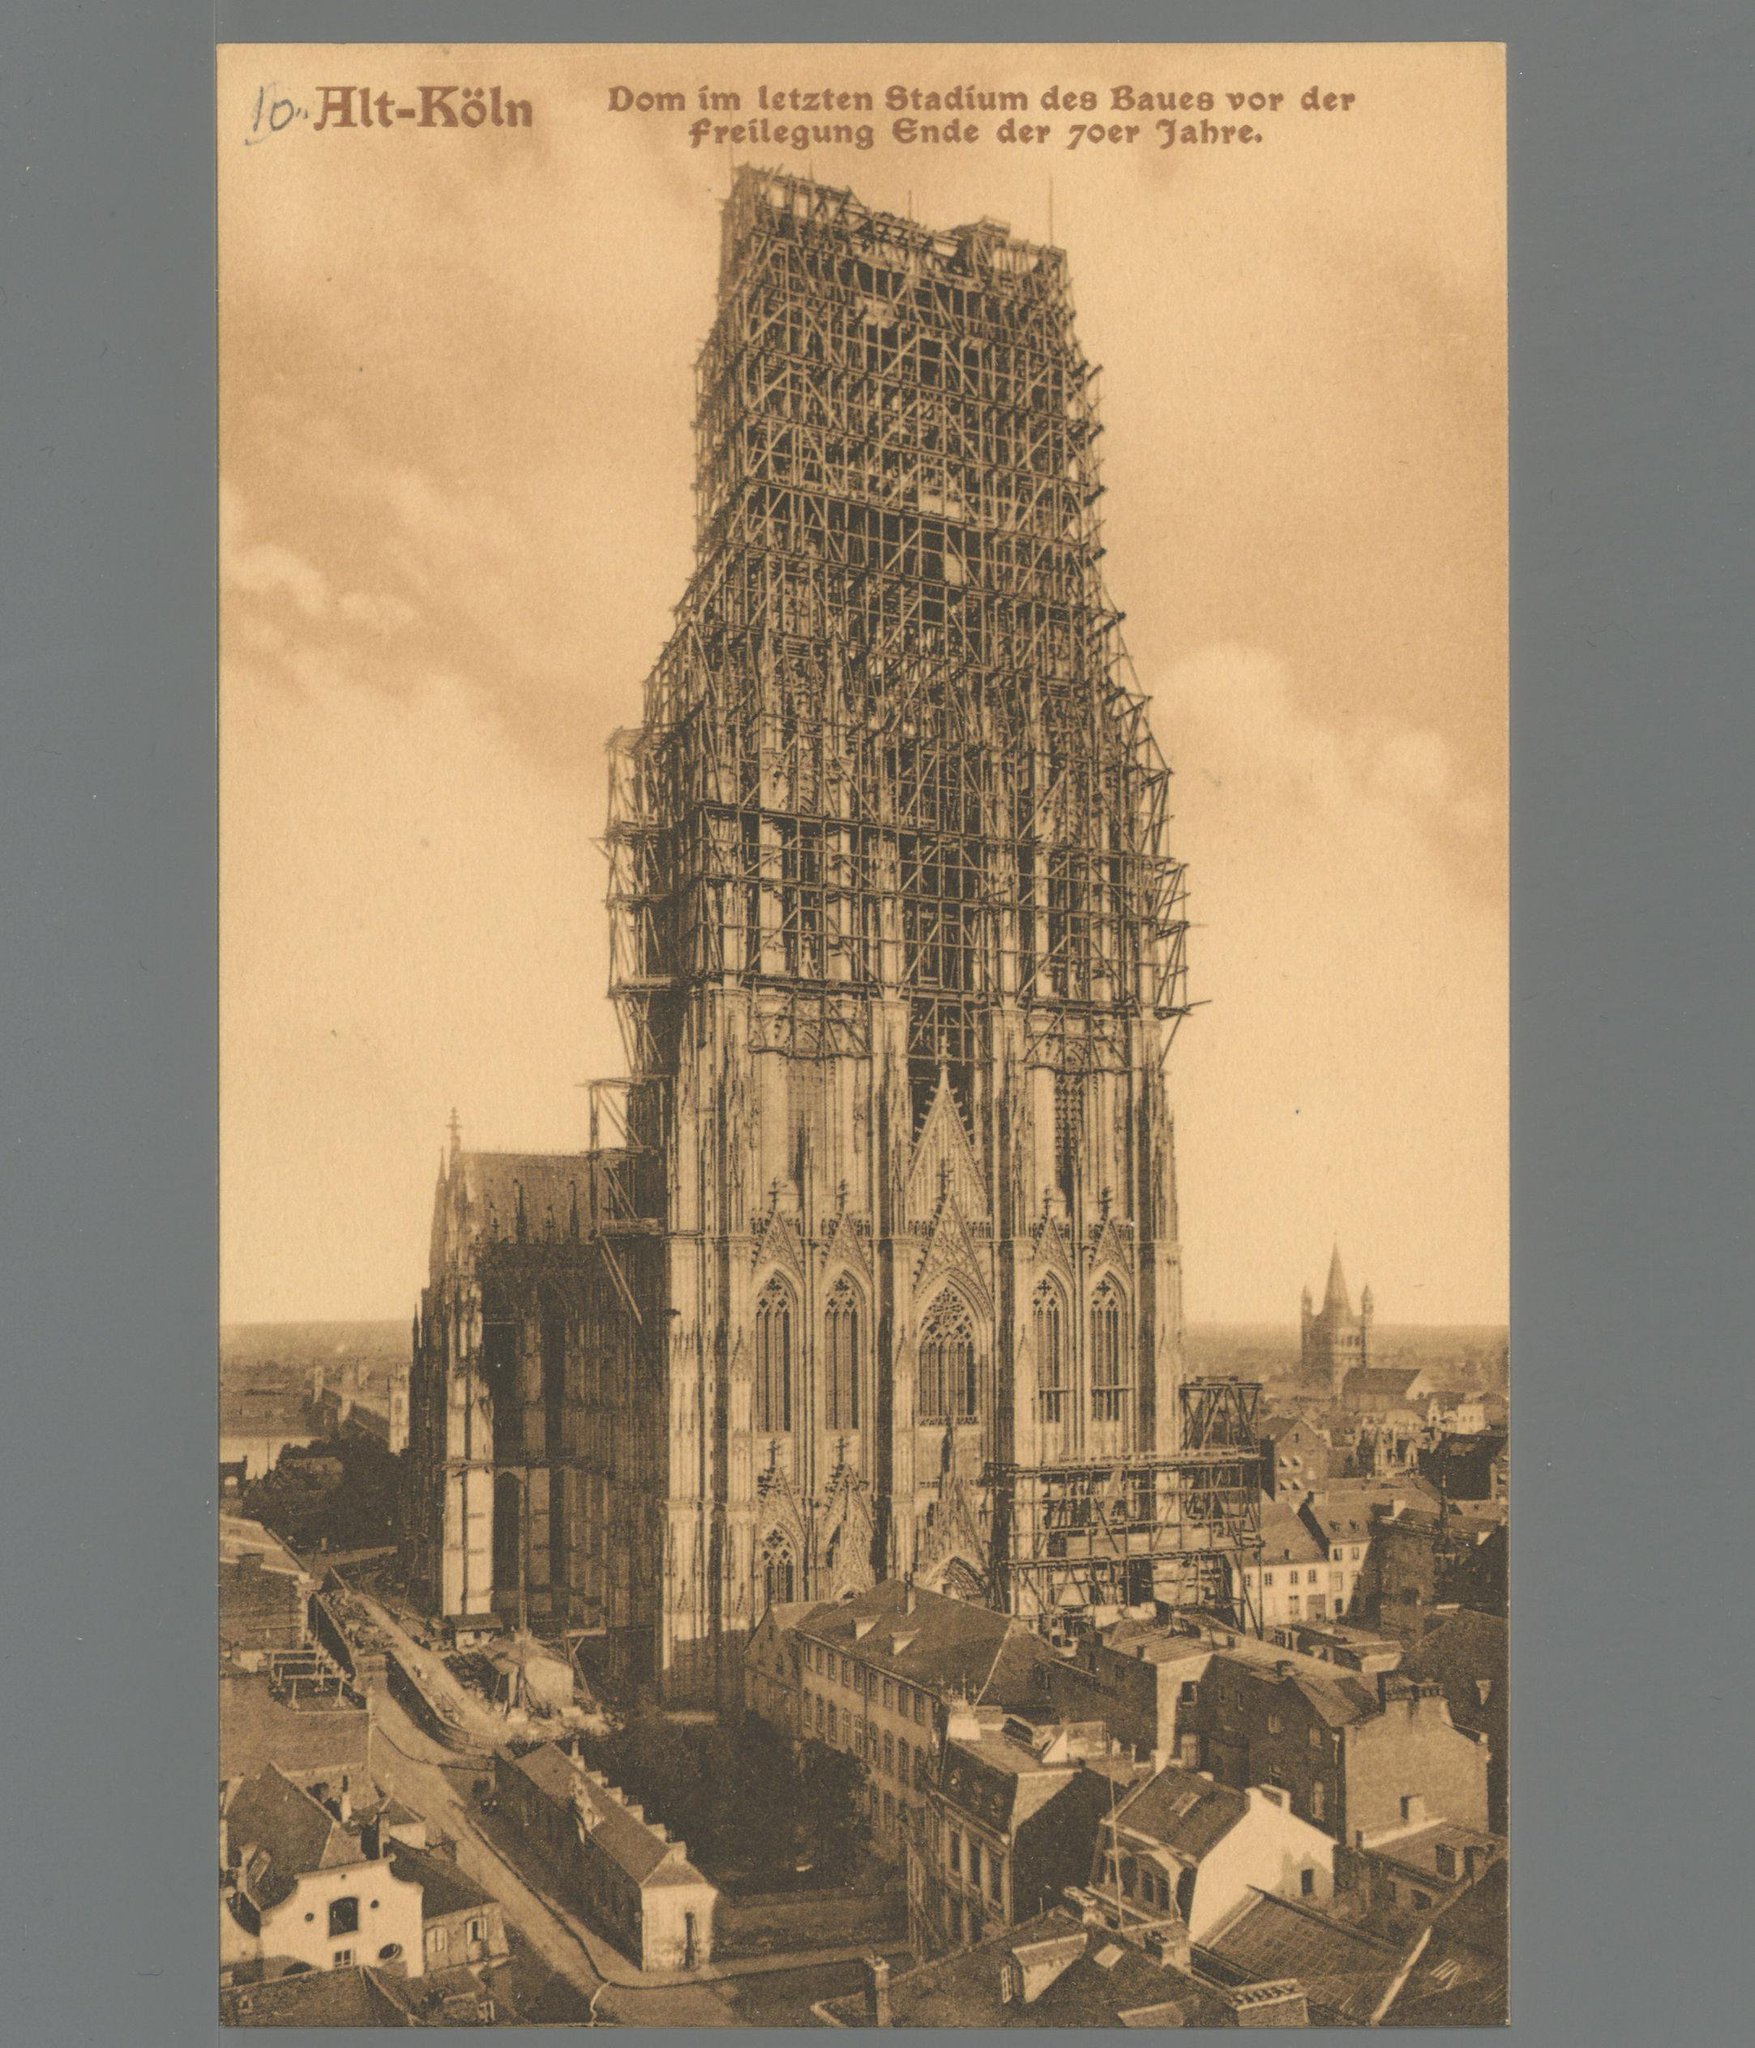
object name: ansichtkaart, prentbriefkaart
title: Alt-Köln. Dom im letzten Stadium des Baues vor der freilegung Ende der 70er Jahre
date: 1905-1920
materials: cardboard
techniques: photograph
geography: cologne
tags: church (exterior), cologne